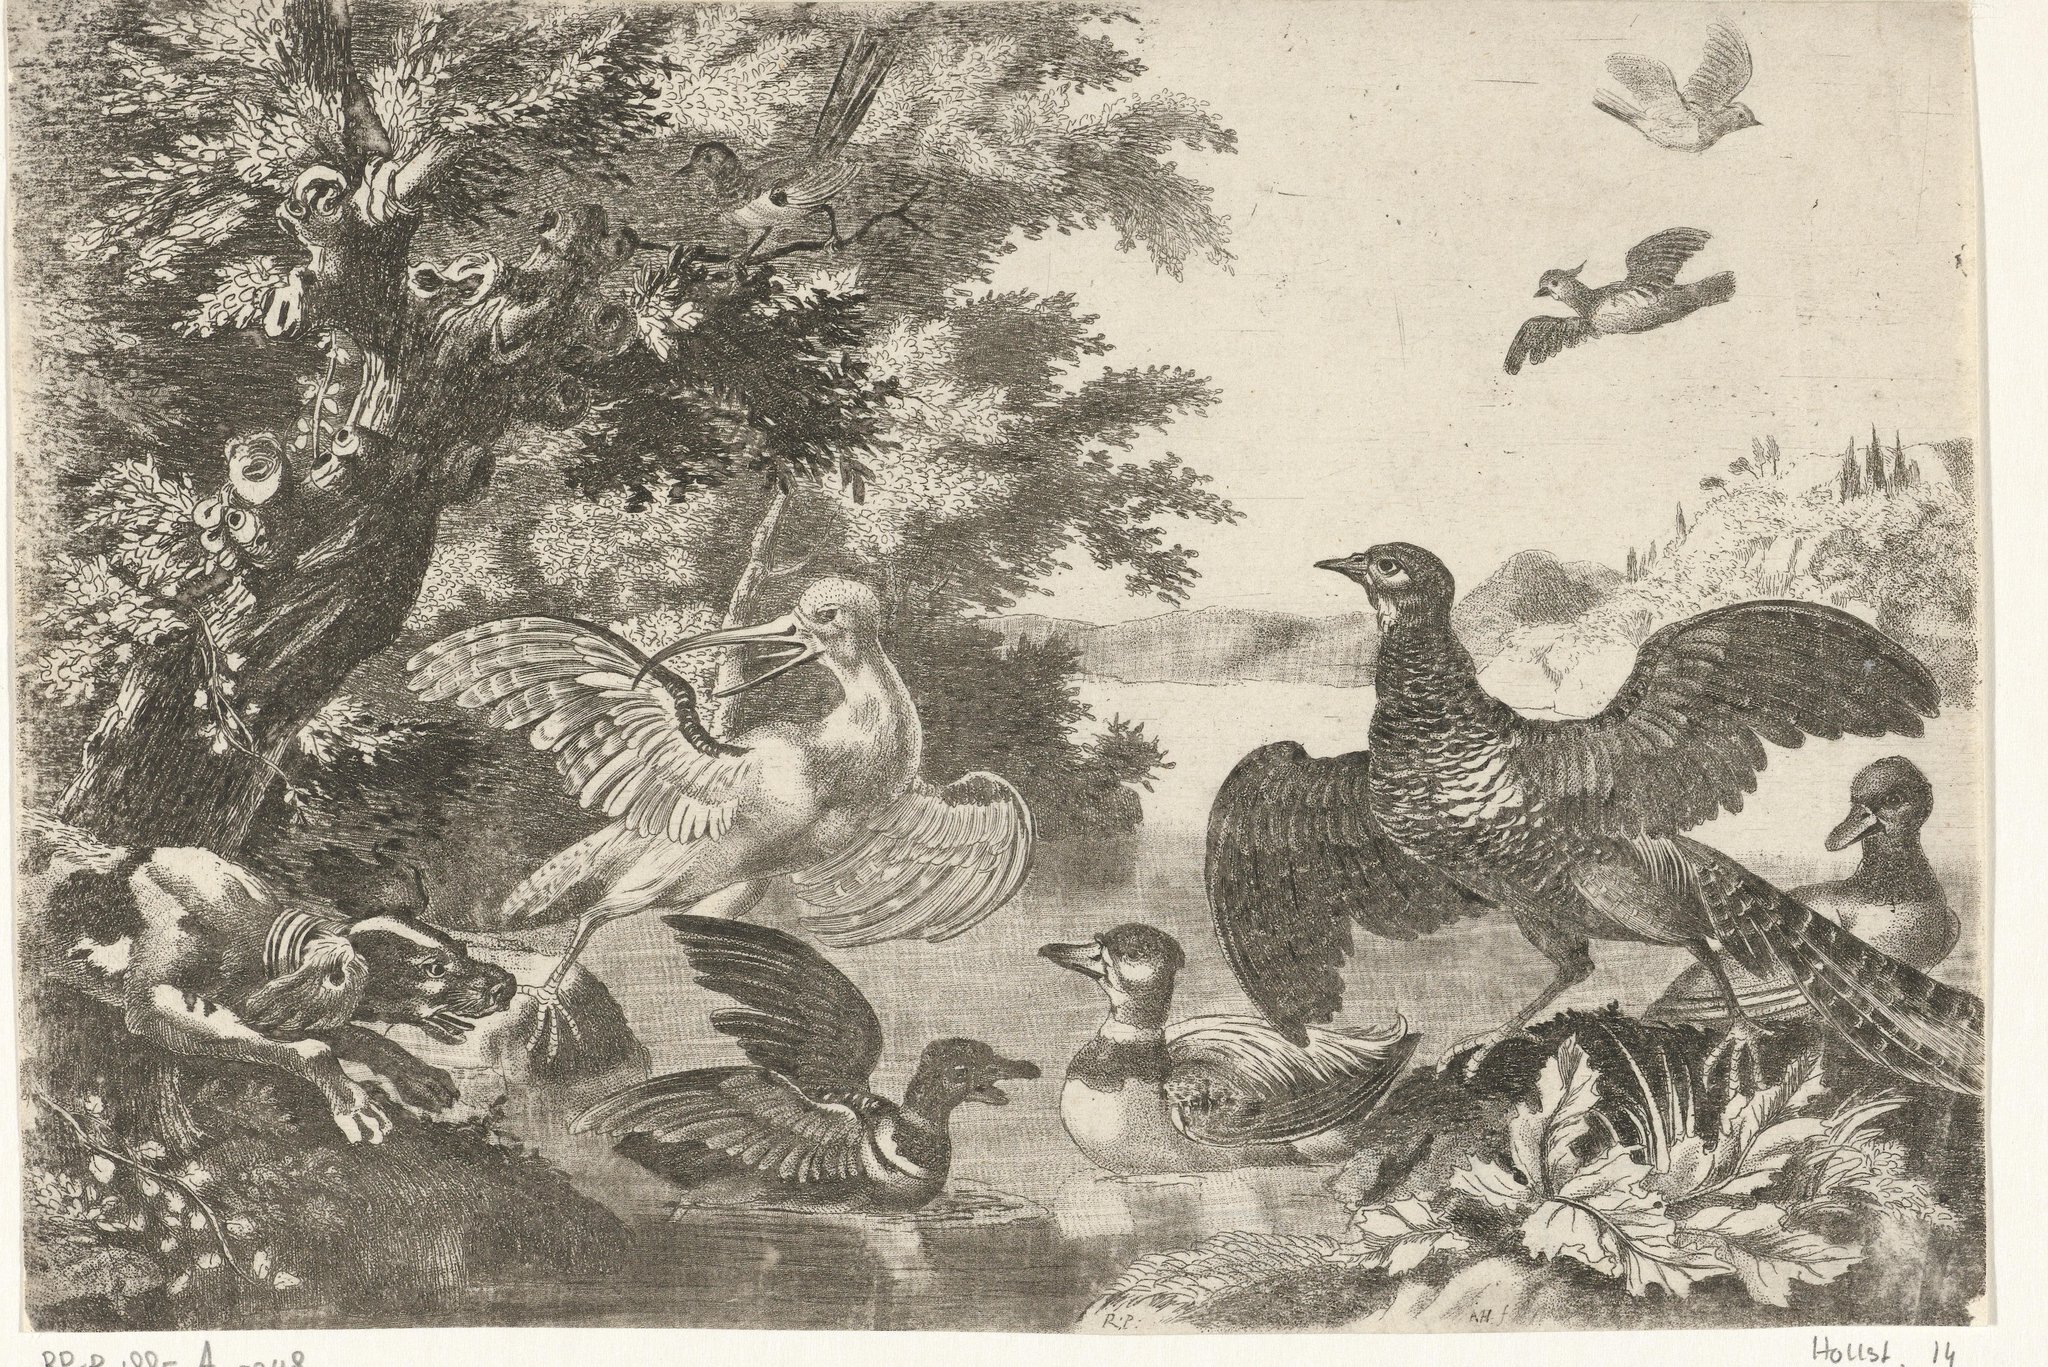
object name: print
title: Watervogels en een hond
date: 1646-1695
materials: paper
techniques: aquatint, etching, roulette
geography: northern netherlands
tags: dog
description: Watervogels op het water in een heuvellandschap worden opgeschrikt door een hond, links aan de waterkant.